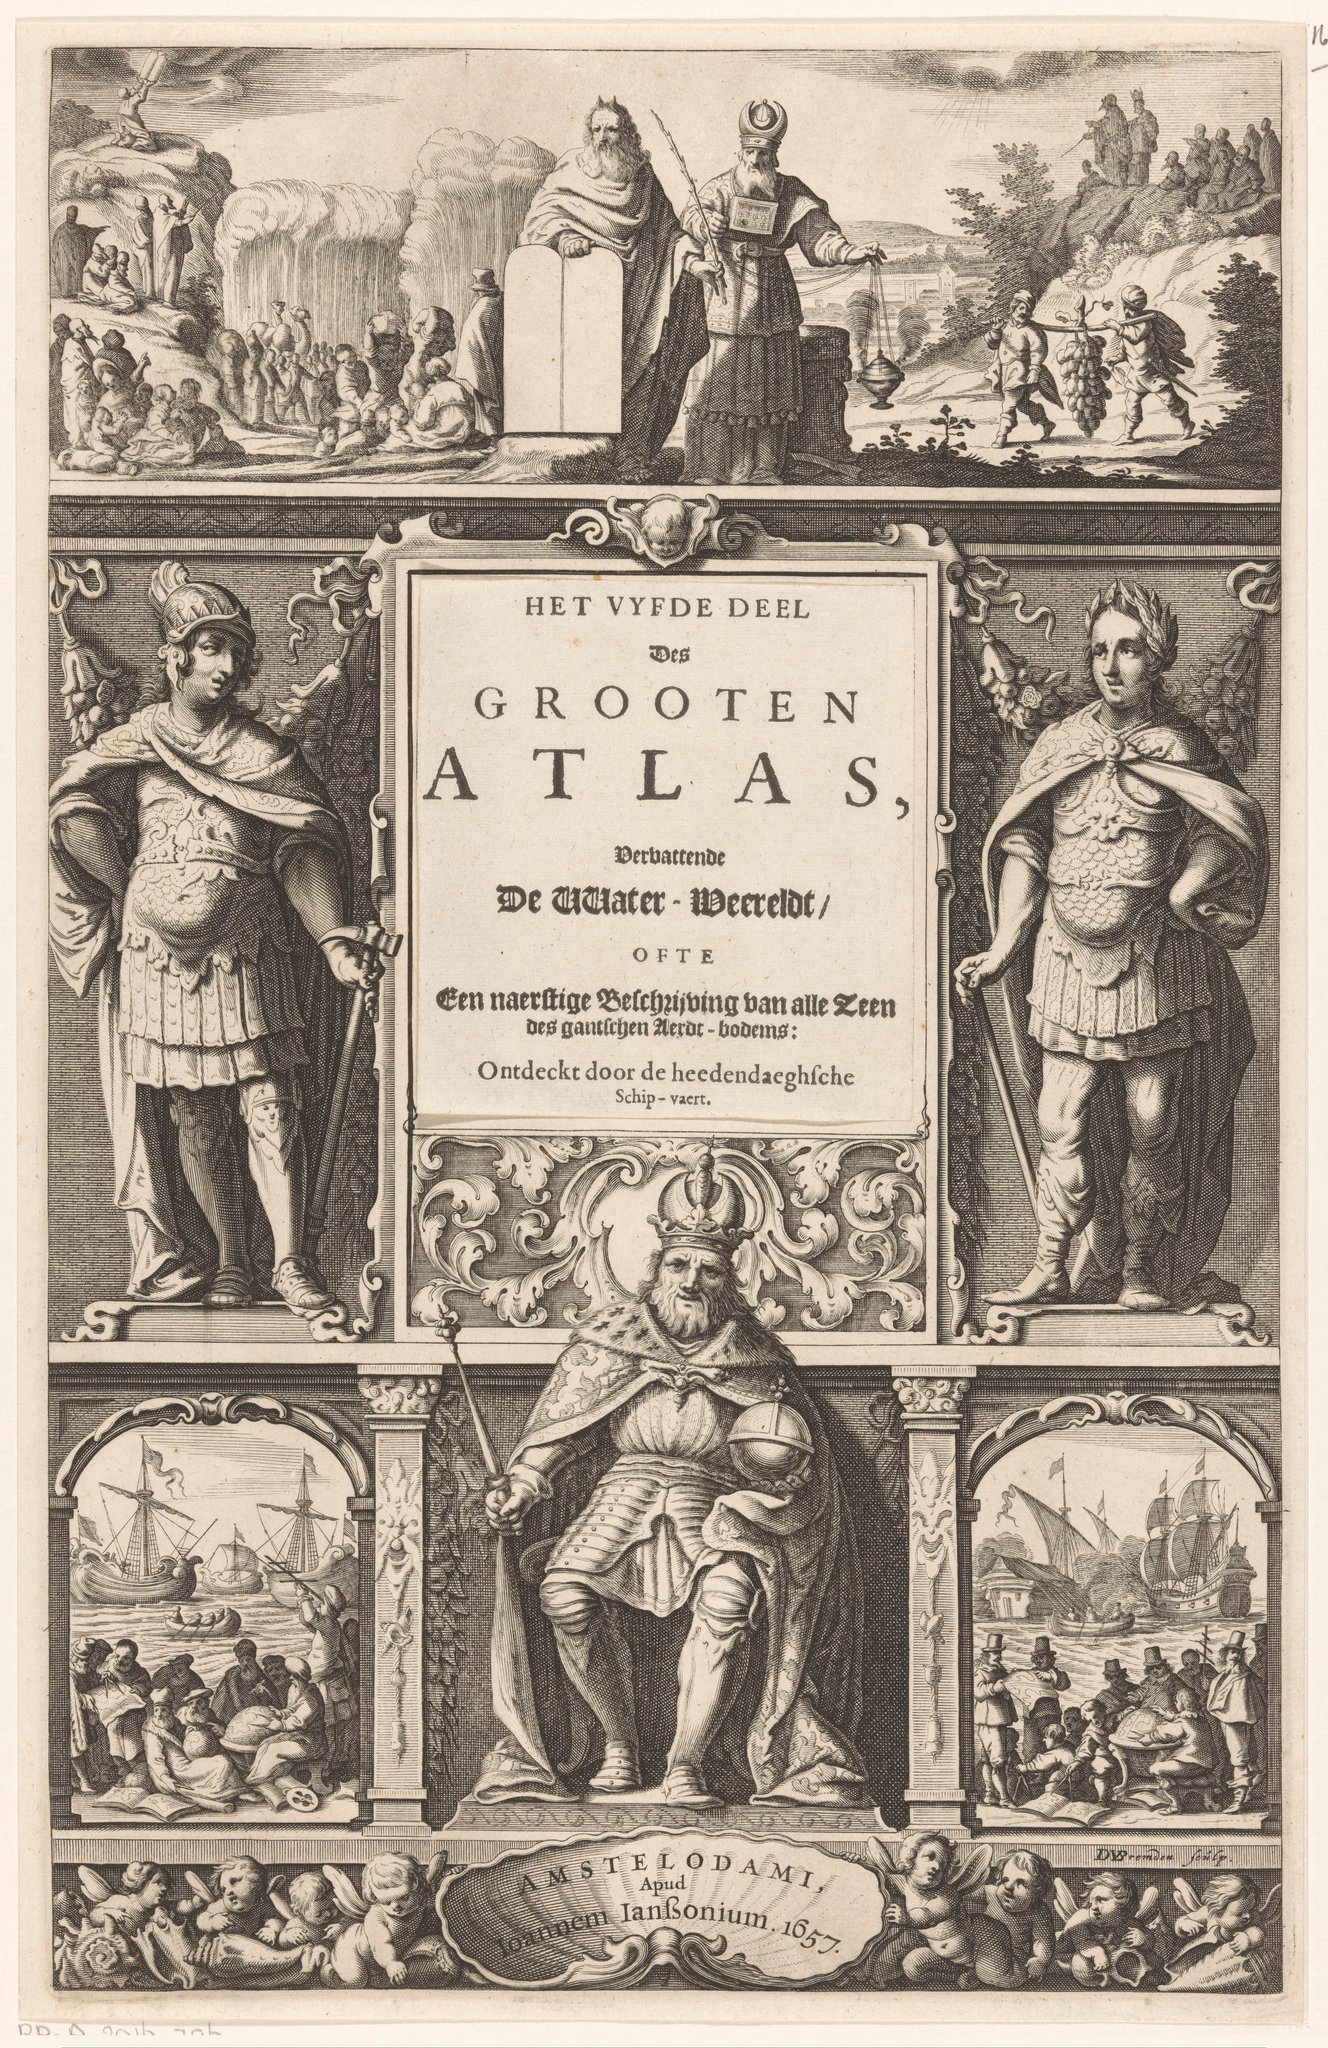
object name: titelblad, titelpagina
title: Titelpagina voor: Johannes Janssonius, Het vyfde deel Des grooten atlas, Vervattende De VVater - Weereldt, 1657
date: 1657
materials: paper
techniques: engraving, letterpress printing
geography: amsterdam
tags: aaron (not in biblical context); possible attributes: attributes of aaron: censer, dressed as high priest or bishop, ointment jar, rod or flowering wand, moses (not in biblical context); possible attributes: rays of light or horns on his head, rod, tables of the law, the soldier; the soldier's life, ruler, sovereign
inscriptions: collector's mark: Lugt 2228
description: Titelpagina voor: Janssonius, Johannes. Het vyfde deel Des grooten atlas, Vervattende De VVater - Weereldt. Amsterdam: Janssonius, Johannes, 1657. Titelpagina oorspronkelijk vervaardigd voor: Janssonius, Johannes. Cinquiesme Partie du Grand Atlas. Amsterdam: Janssonius, Johannes, 1657. Prent afkomstig uit een plakalbum met titelprenten, ornamenten etc. op blauw papier in 1983 uit elkaar gehaald.